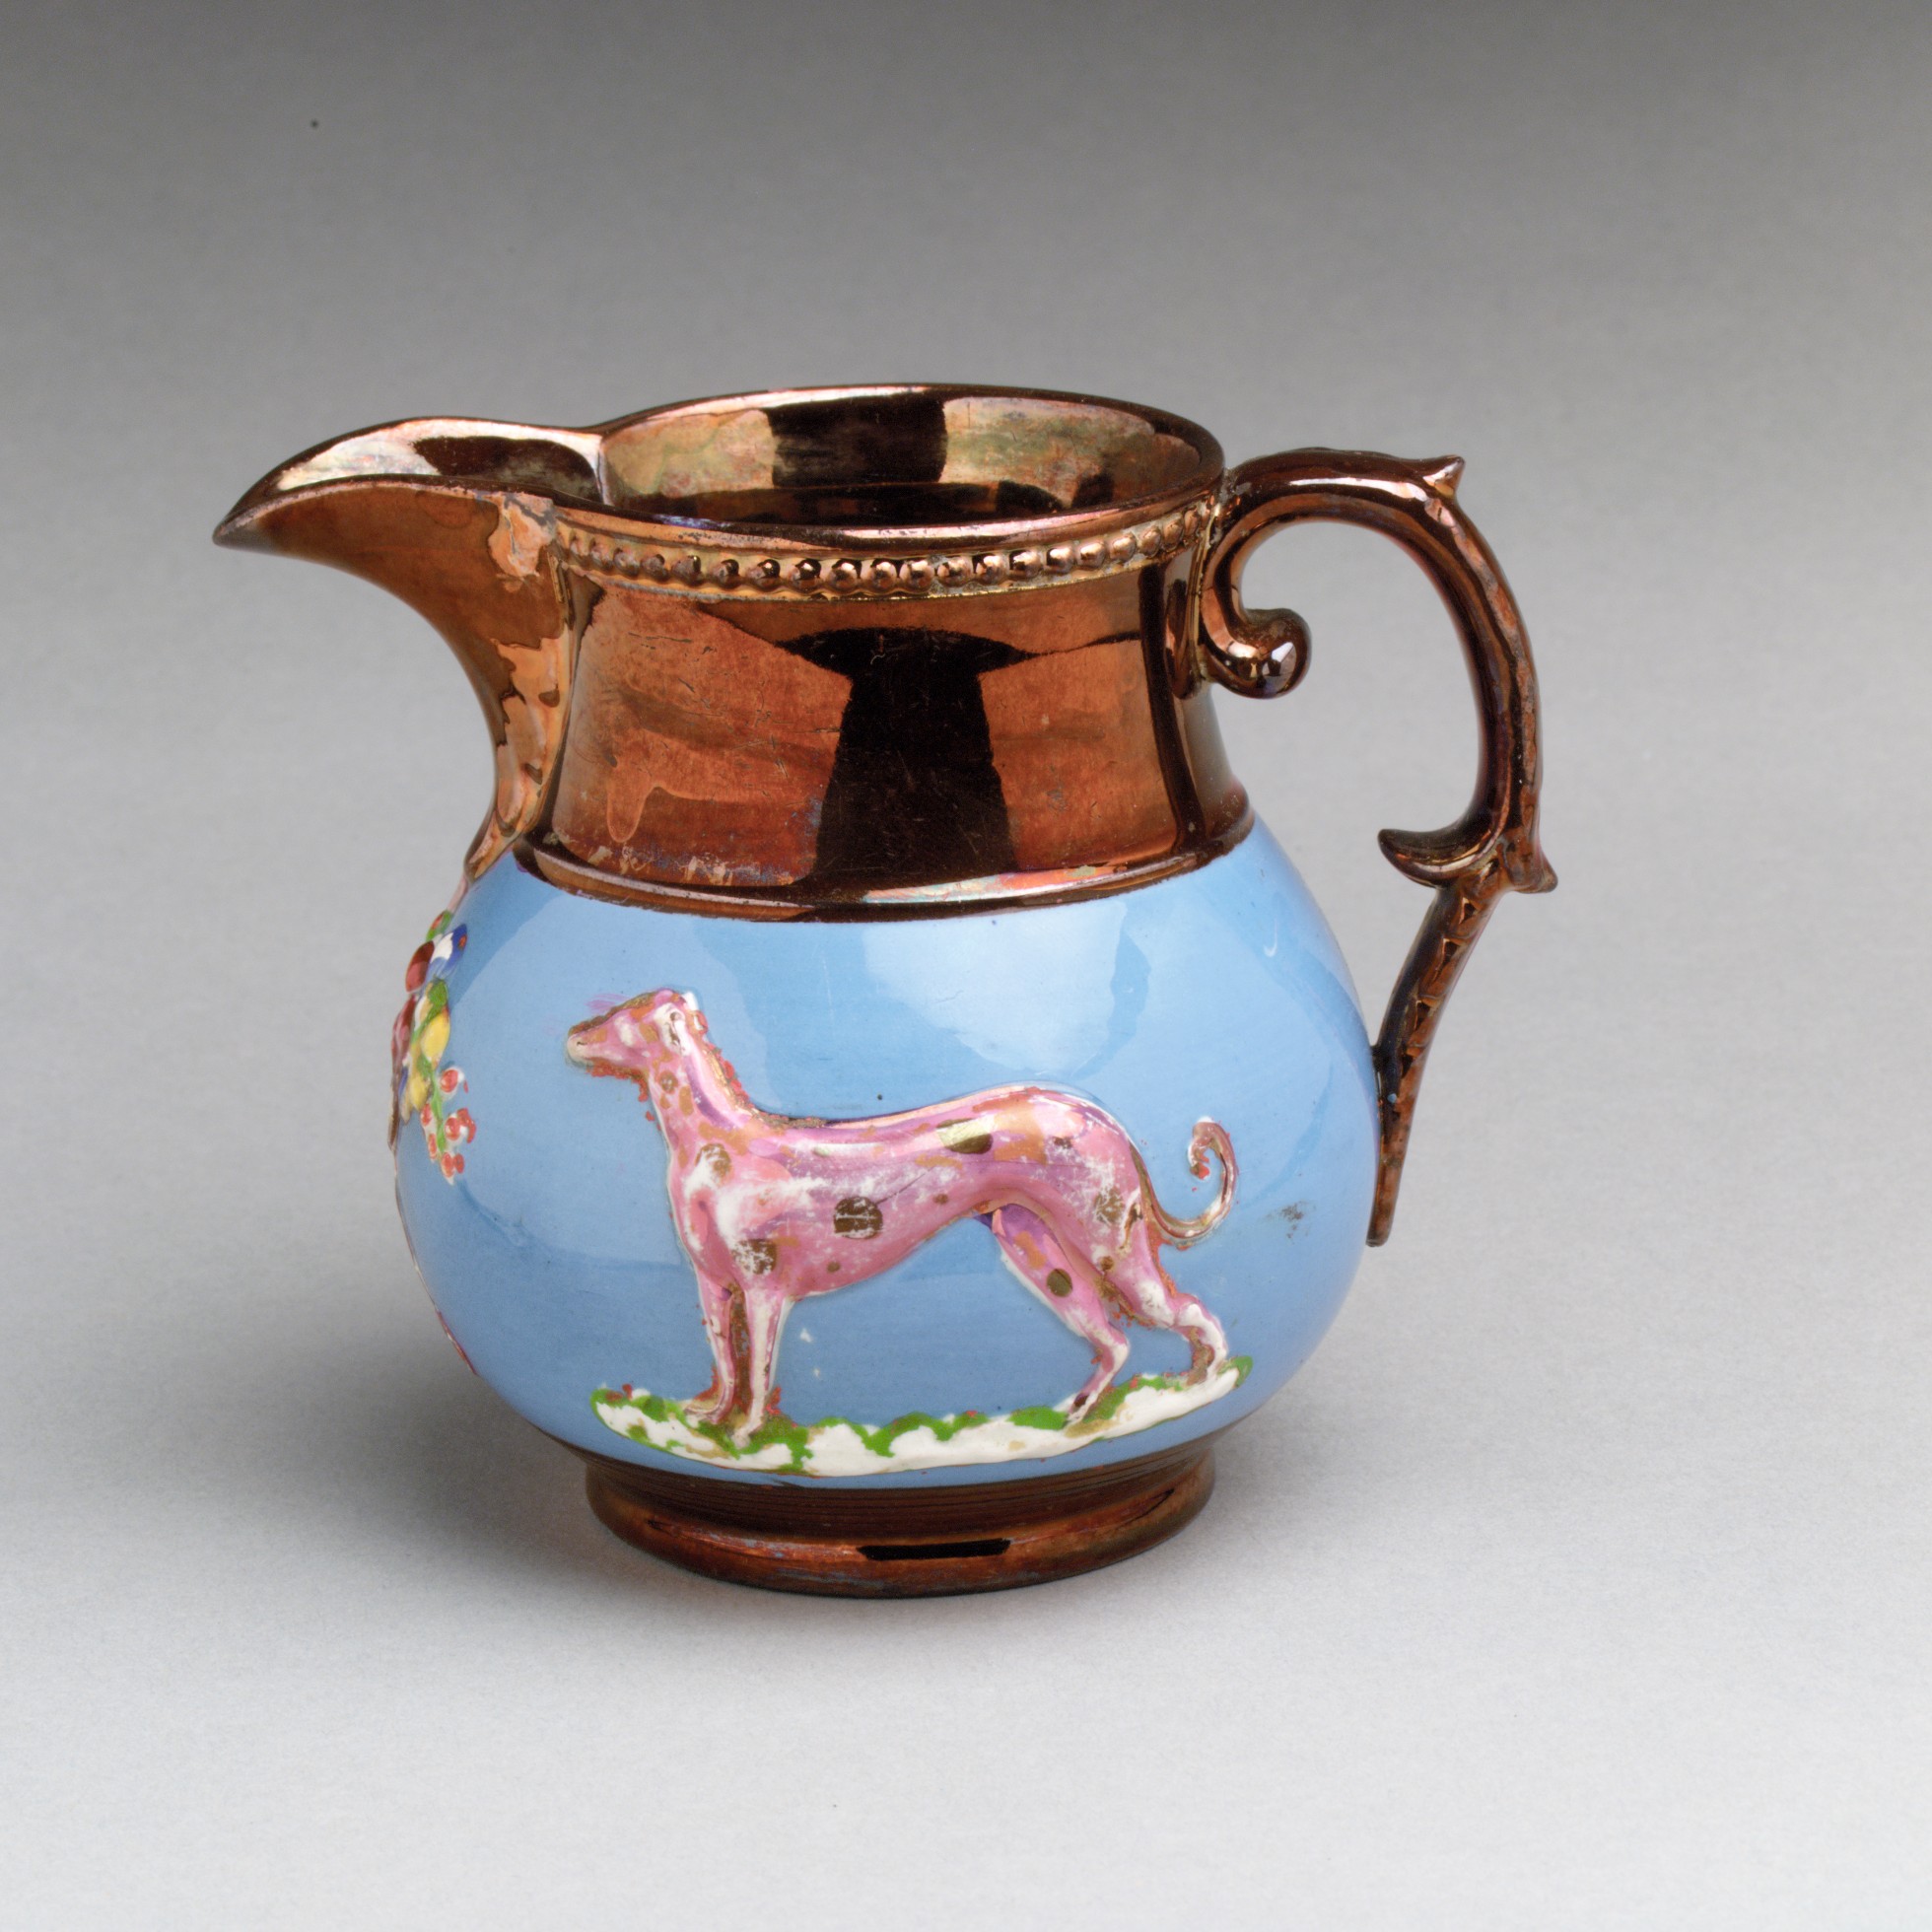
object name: pitcher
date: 1801-1900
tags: dogs